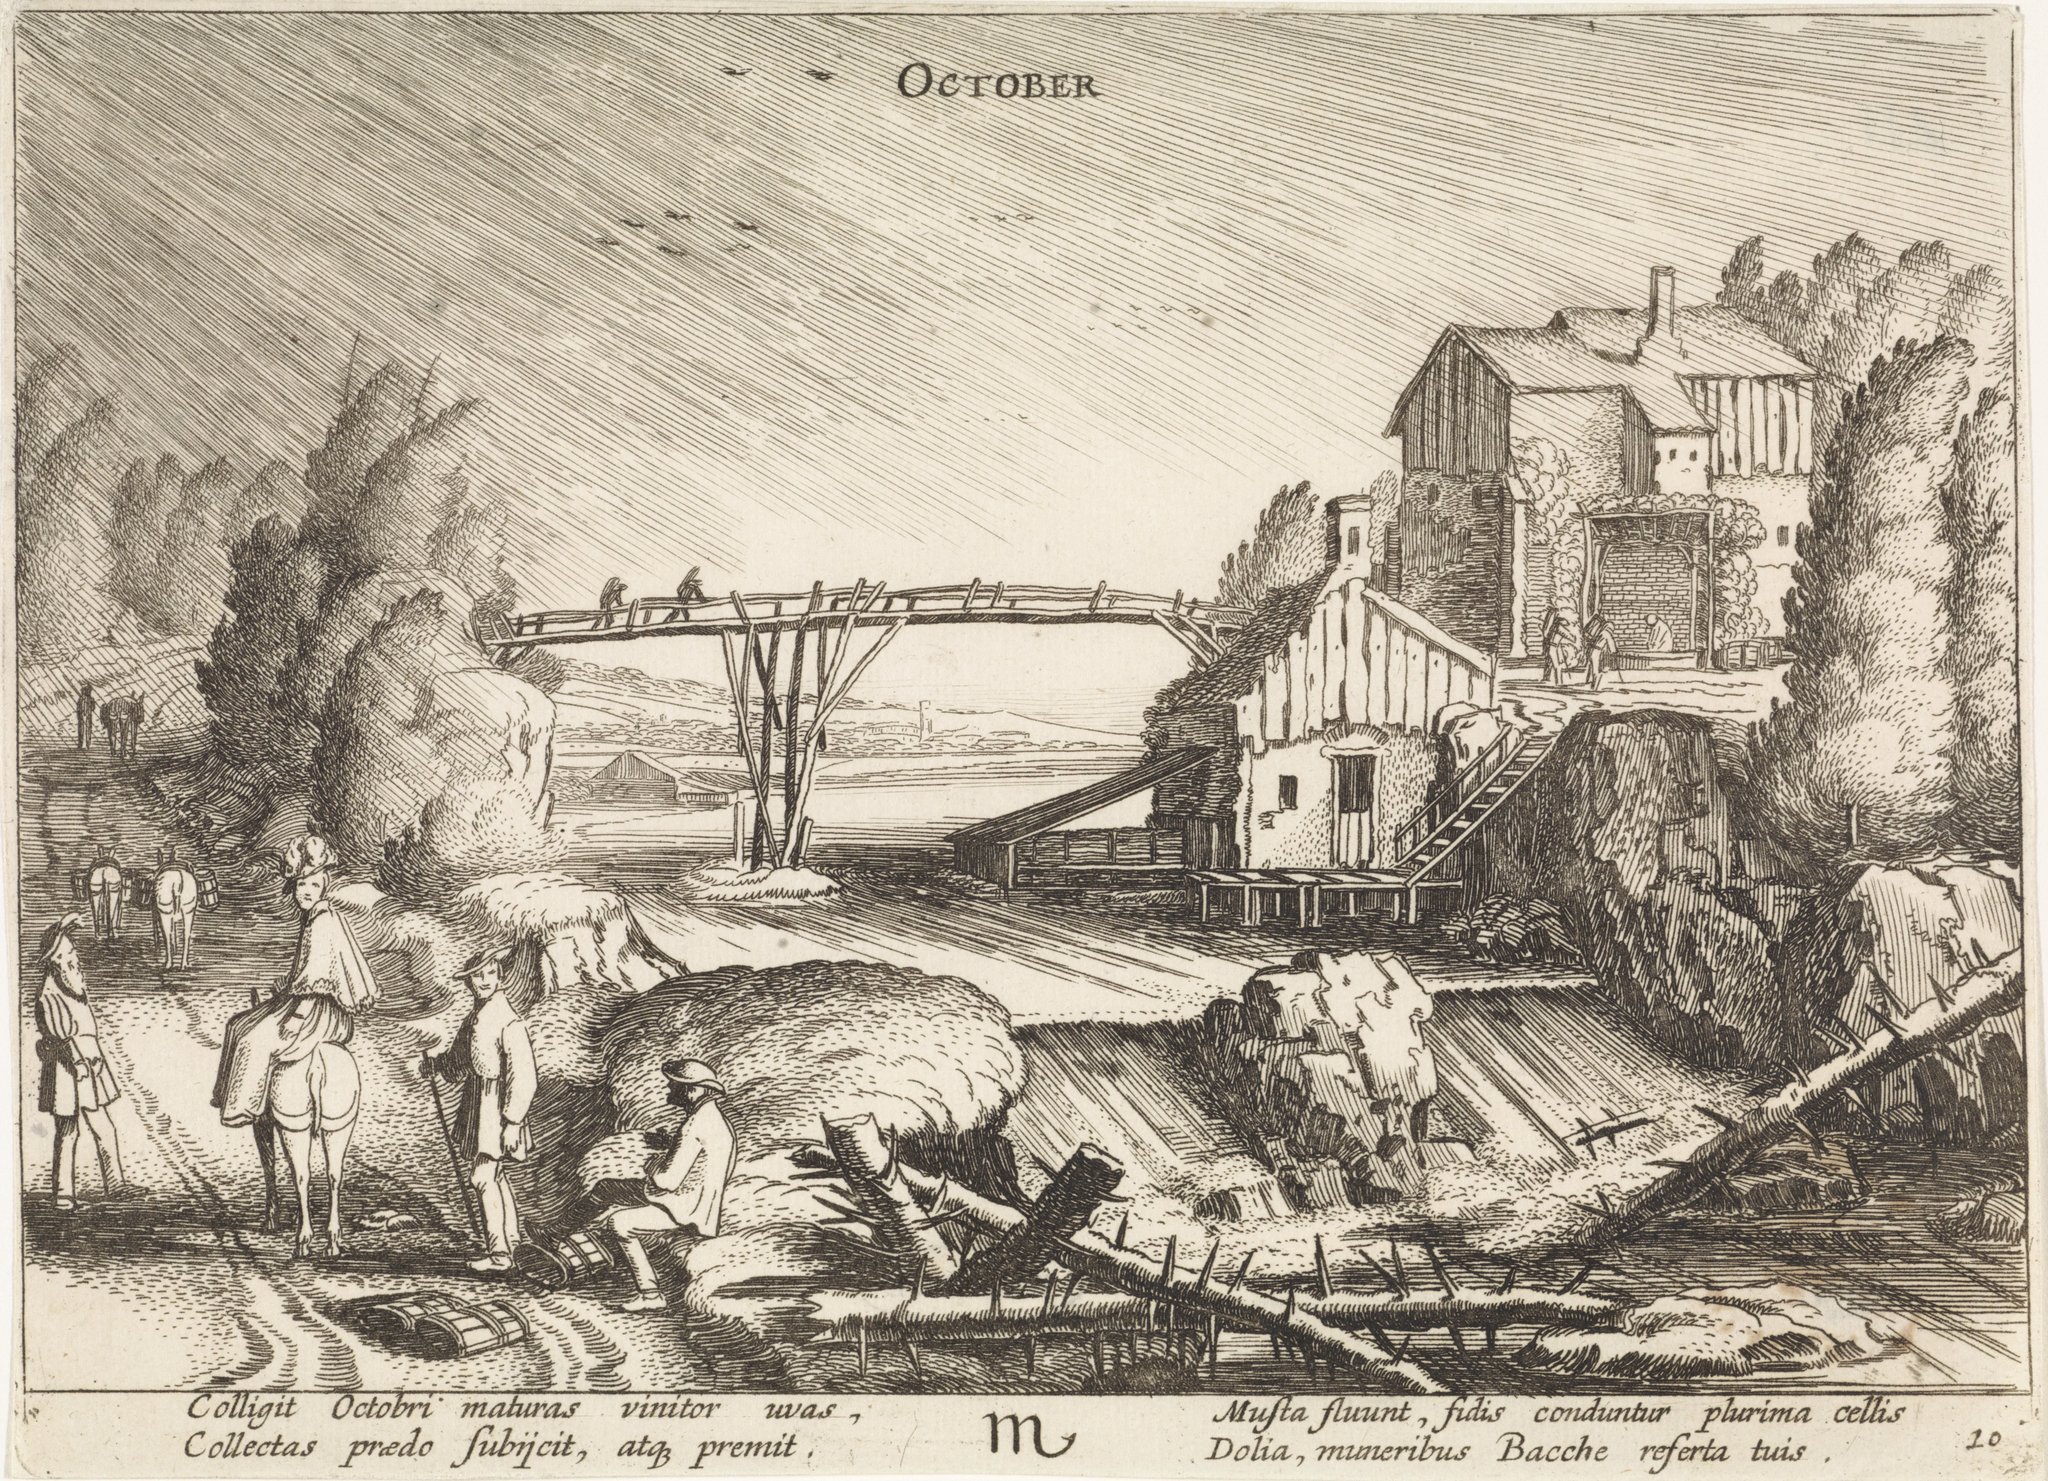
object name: print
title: October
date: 1608-1618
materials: paper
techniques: engraving, etching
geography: northern netherlands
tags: landscape symbolizing september, libra (zodiacal sign of september), landscape with tower or castle, tow-boat, towing-barge, towing path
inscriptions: collector's mark: Lugt 698, collector's mark: Lugt 240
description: Een rivierlandschap met figuren op een landweg in de regen, voorstellende de maand oktober. In het midden een houten brug. Rechts een huis met een man in een wijnkuip. Onderaan het astrologische symbool van het sterrenbeeld schorpioen. Prent uit een serie van twaalf.